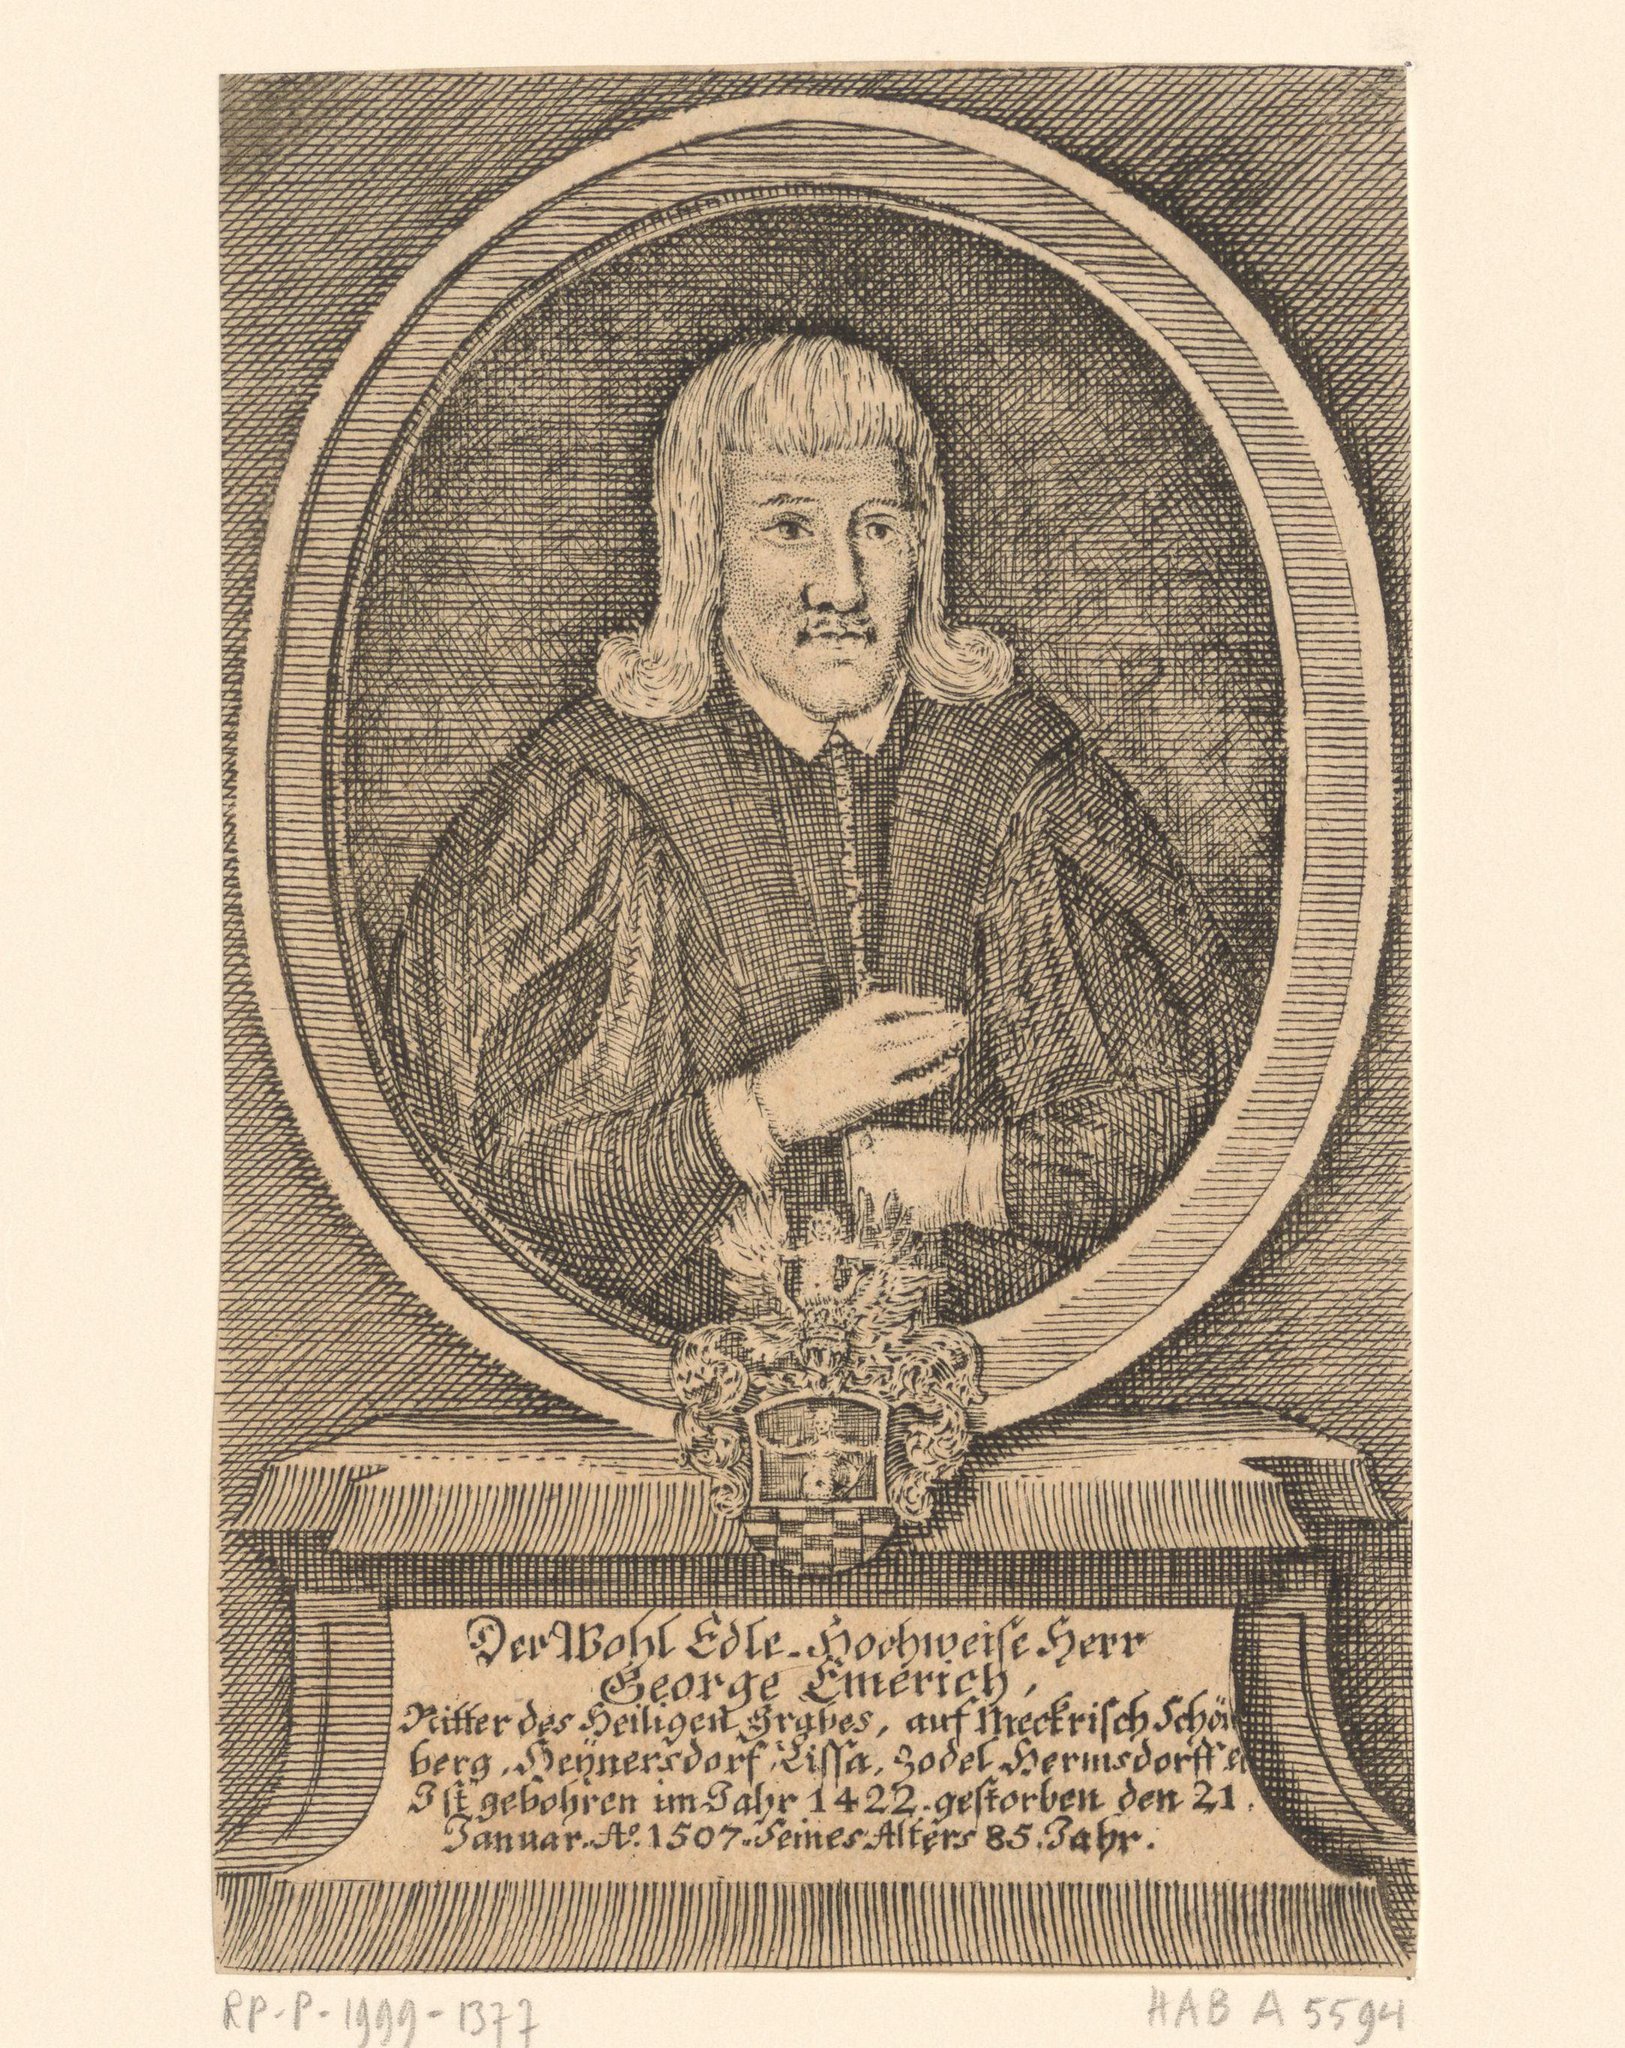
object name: print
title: Portret van George Emerich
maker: Anonymous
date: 1730-1780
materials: paper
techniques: engraving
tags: mayor, historical persons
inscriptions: collector's mark: Lugt 2760, collector's mark: Lugt 2228